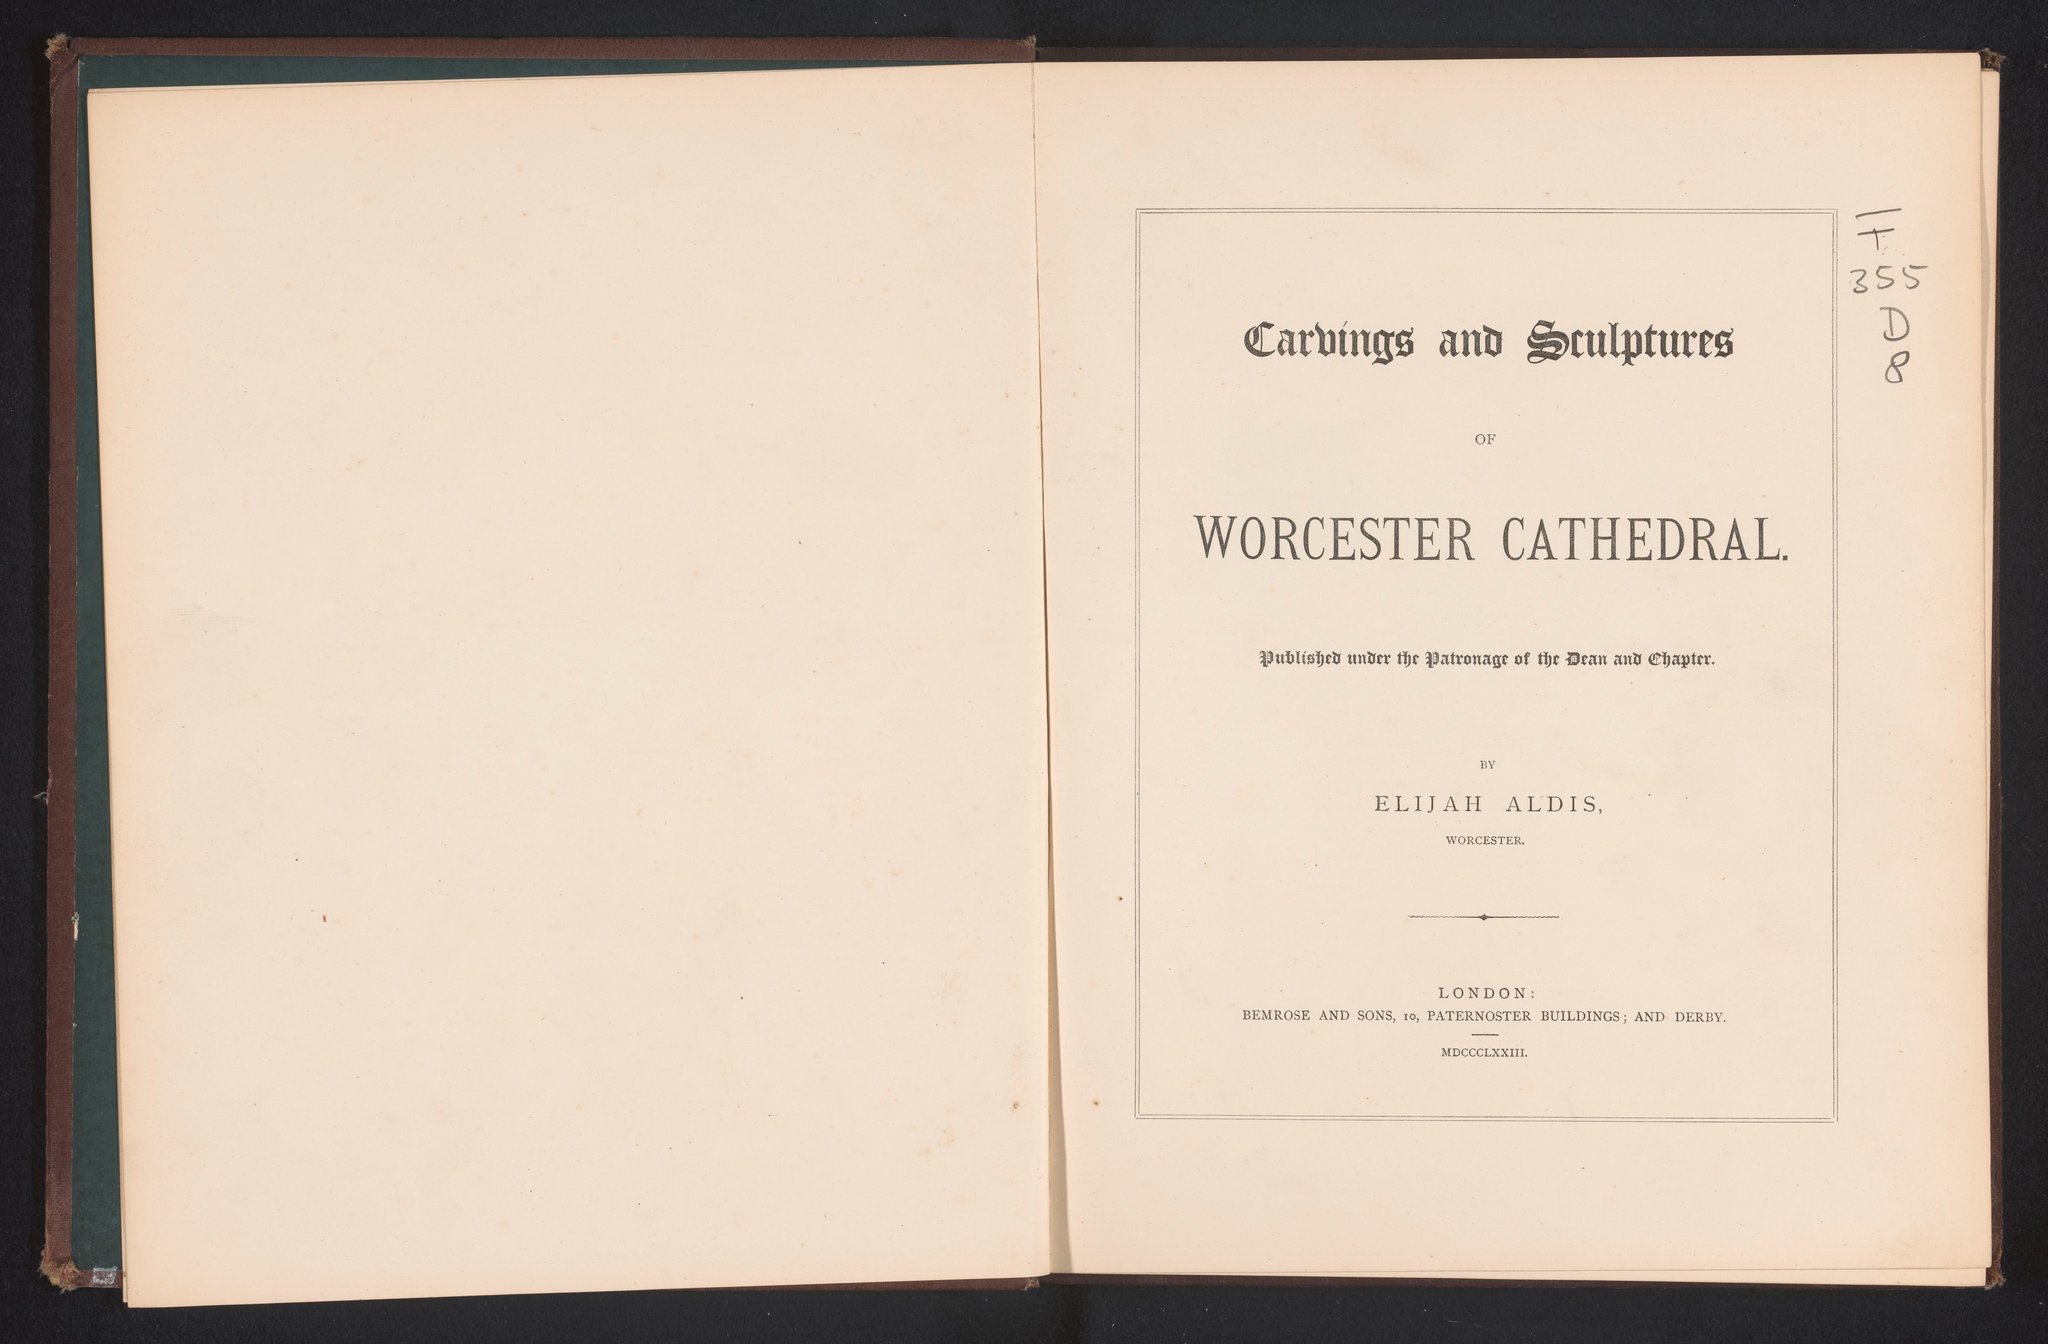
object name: book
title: Carvings and sculptures of the Worcester Cathedral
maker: elijah aldis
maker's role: schrijver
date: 1873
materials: cardboard, linen, paper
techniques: printing, woodburytype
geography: london